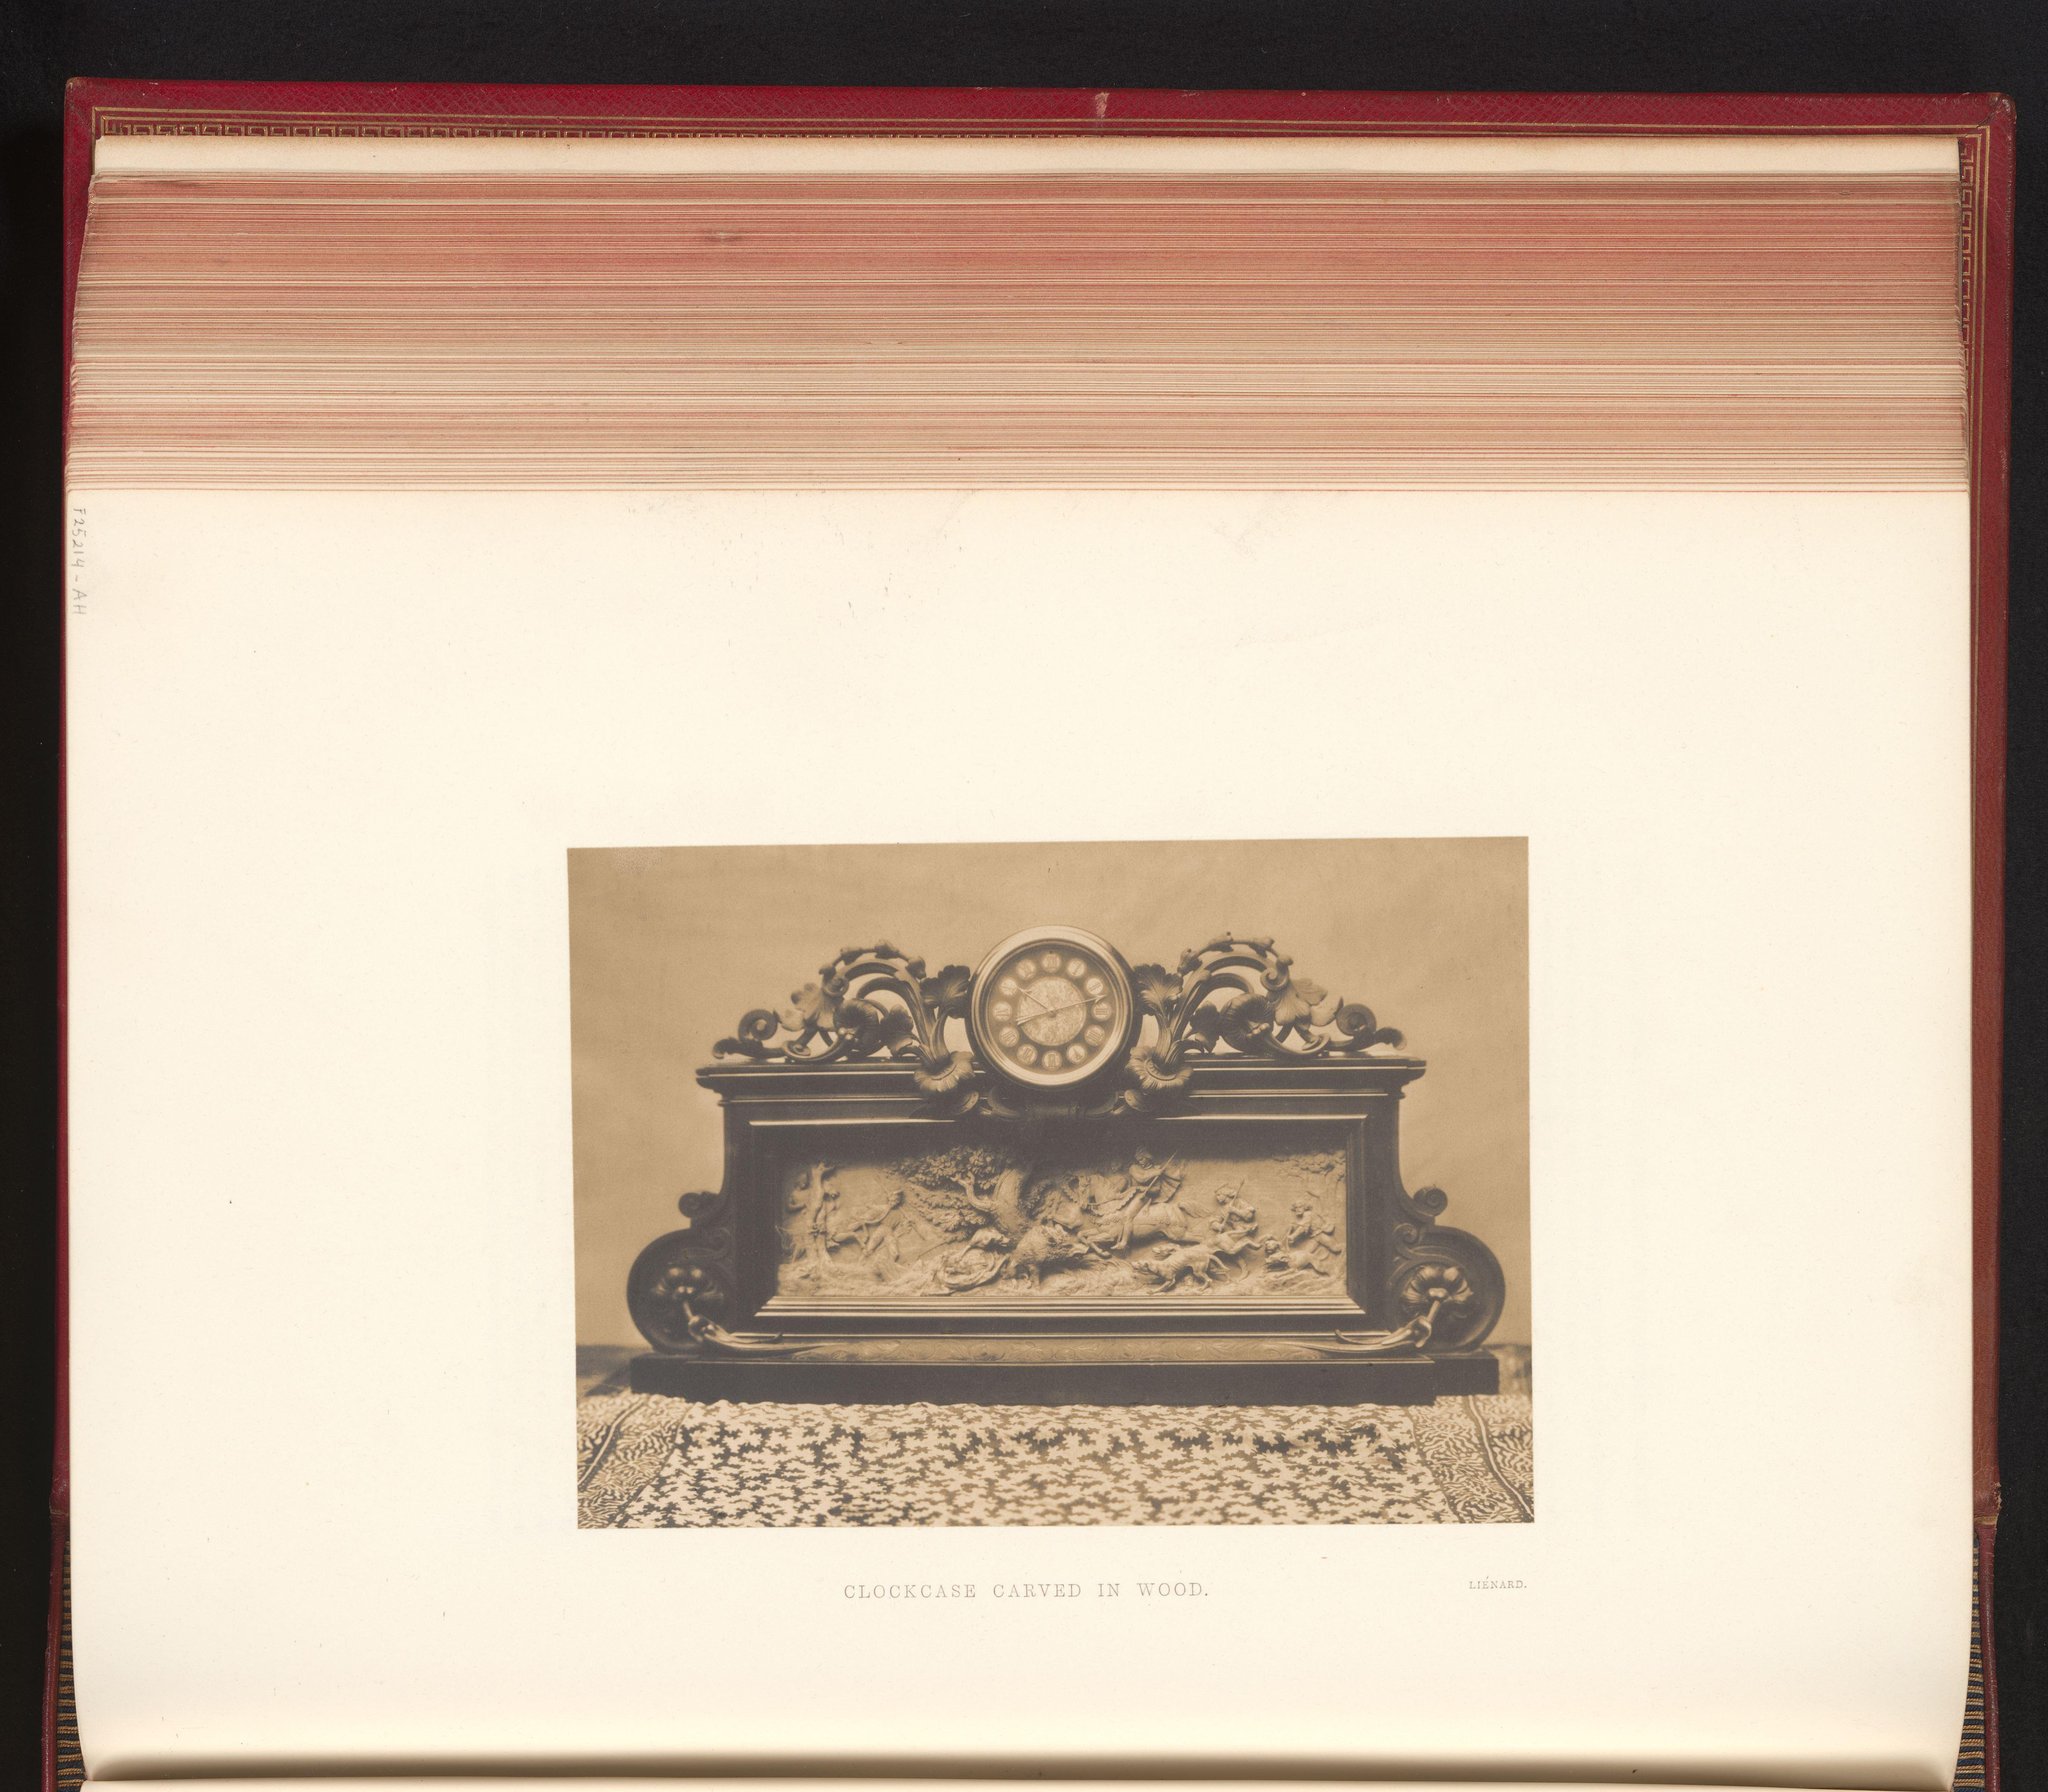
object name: page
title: Clockcase carved in Wood. Liénard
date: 1851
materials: photographic support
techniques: salted paper print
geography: london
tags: clock, london